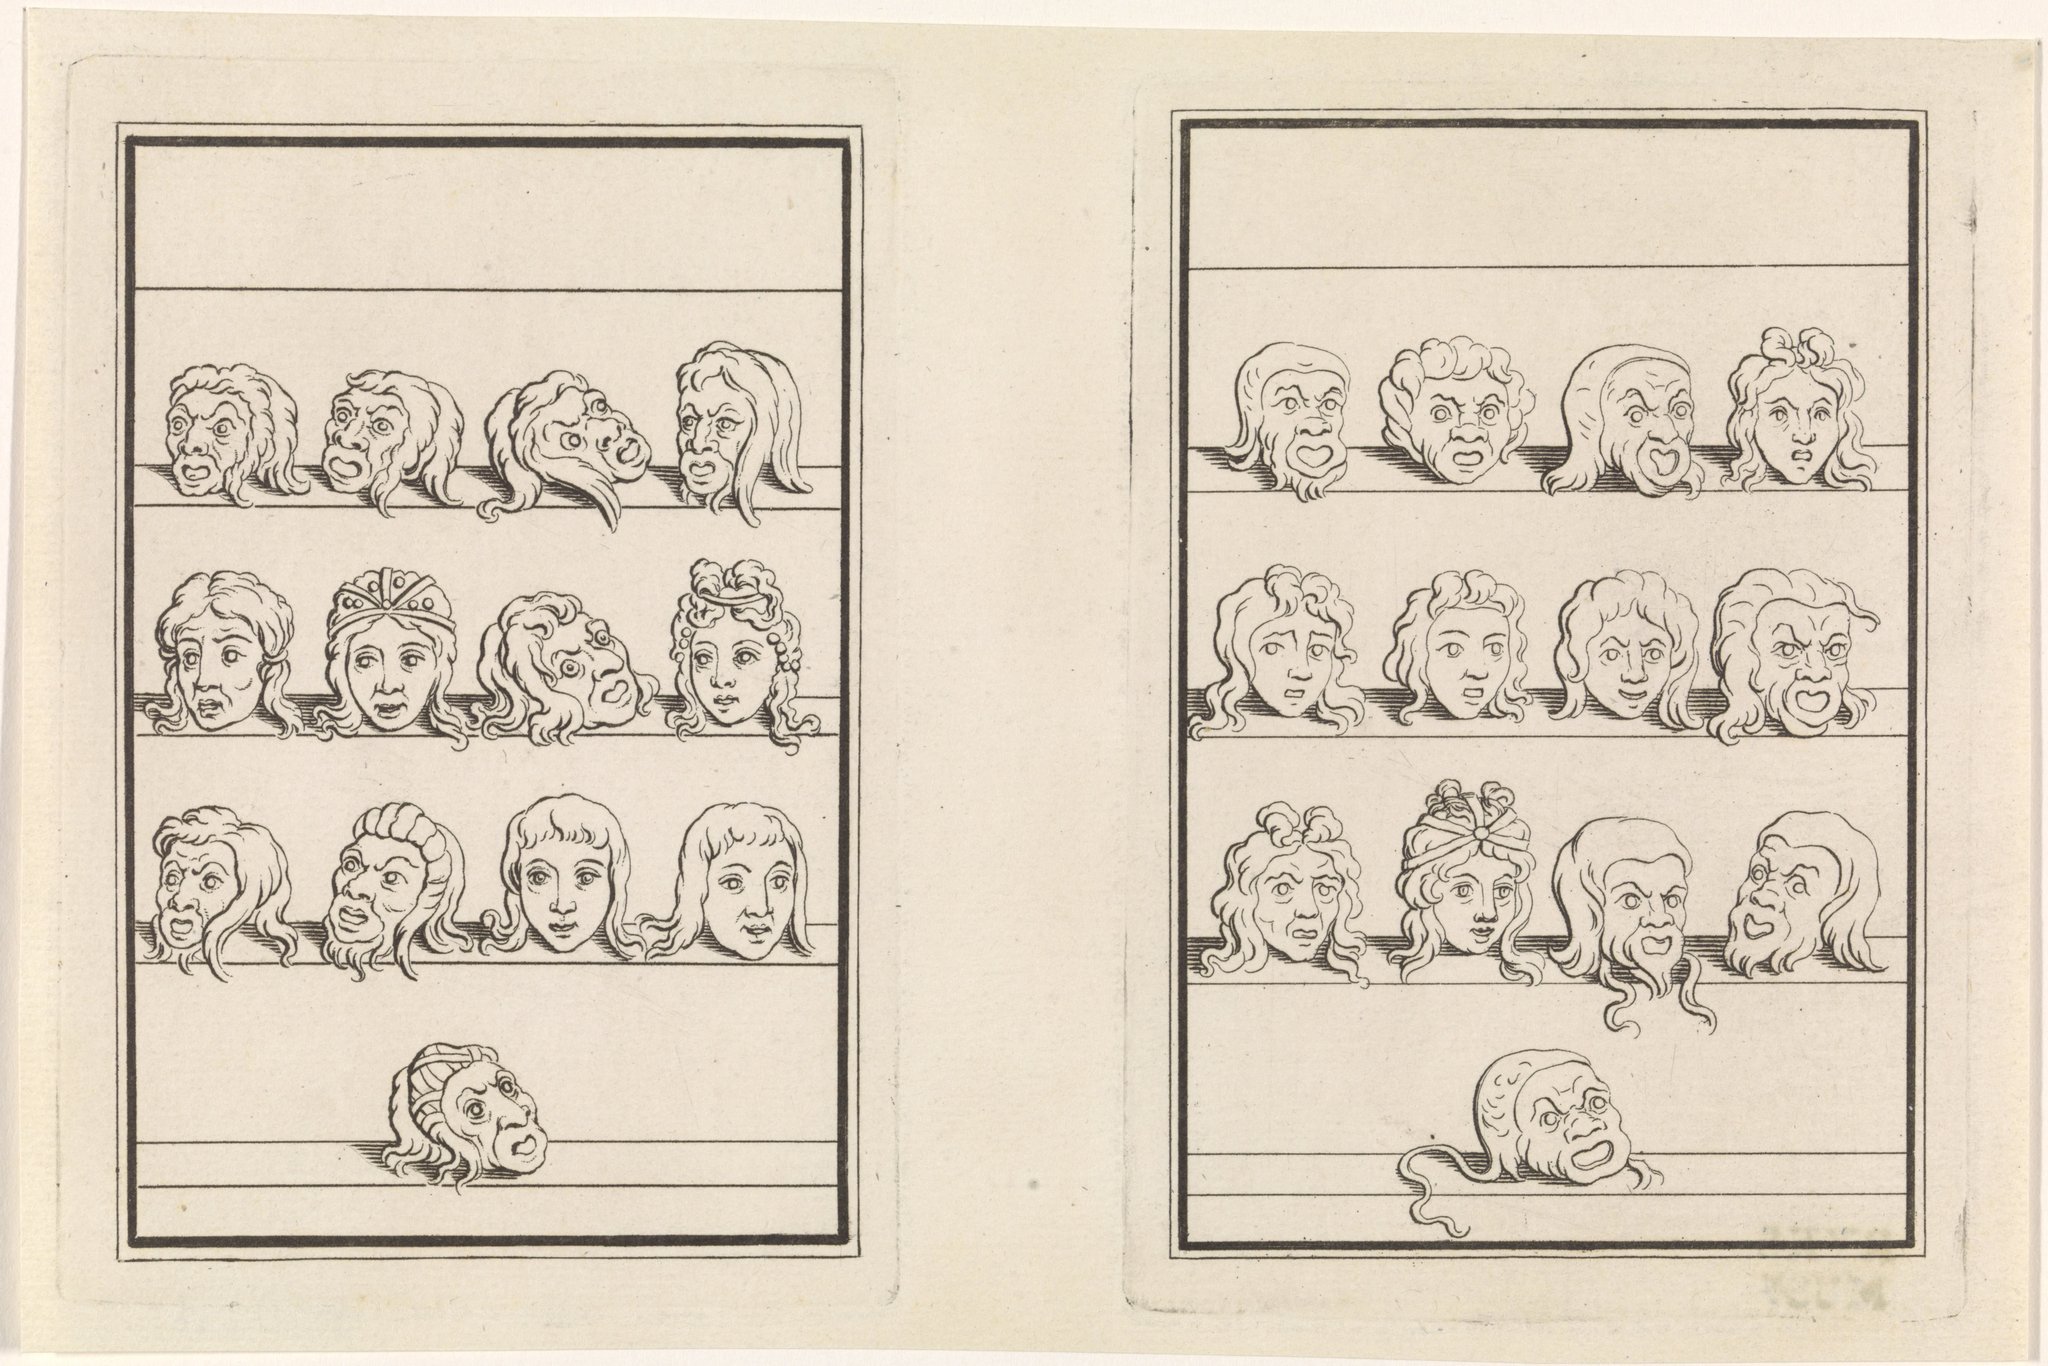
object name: print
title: Maskers van personages uit de komedies Adelphoe en Andria van Terentius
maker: bernard picart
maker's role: draughtsman, print maker, publisher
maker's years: 1673-1733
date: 1716-1718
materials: paper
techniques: engraving, etching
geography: amsterdam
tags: mask, specific works of literature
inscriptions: collector's mark: Lugt 2165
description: Definitieve staat van deze prenten ook gebruikt als illustratie in: Terentius, Publius. Les comedies de Terence: avec la traduction et les remarques, deel II, na p. 254 en deel I, na p. 10. [Geannoteerd door] Anne Dacier. Rotterdam: Caspar Fritsch, 1717.